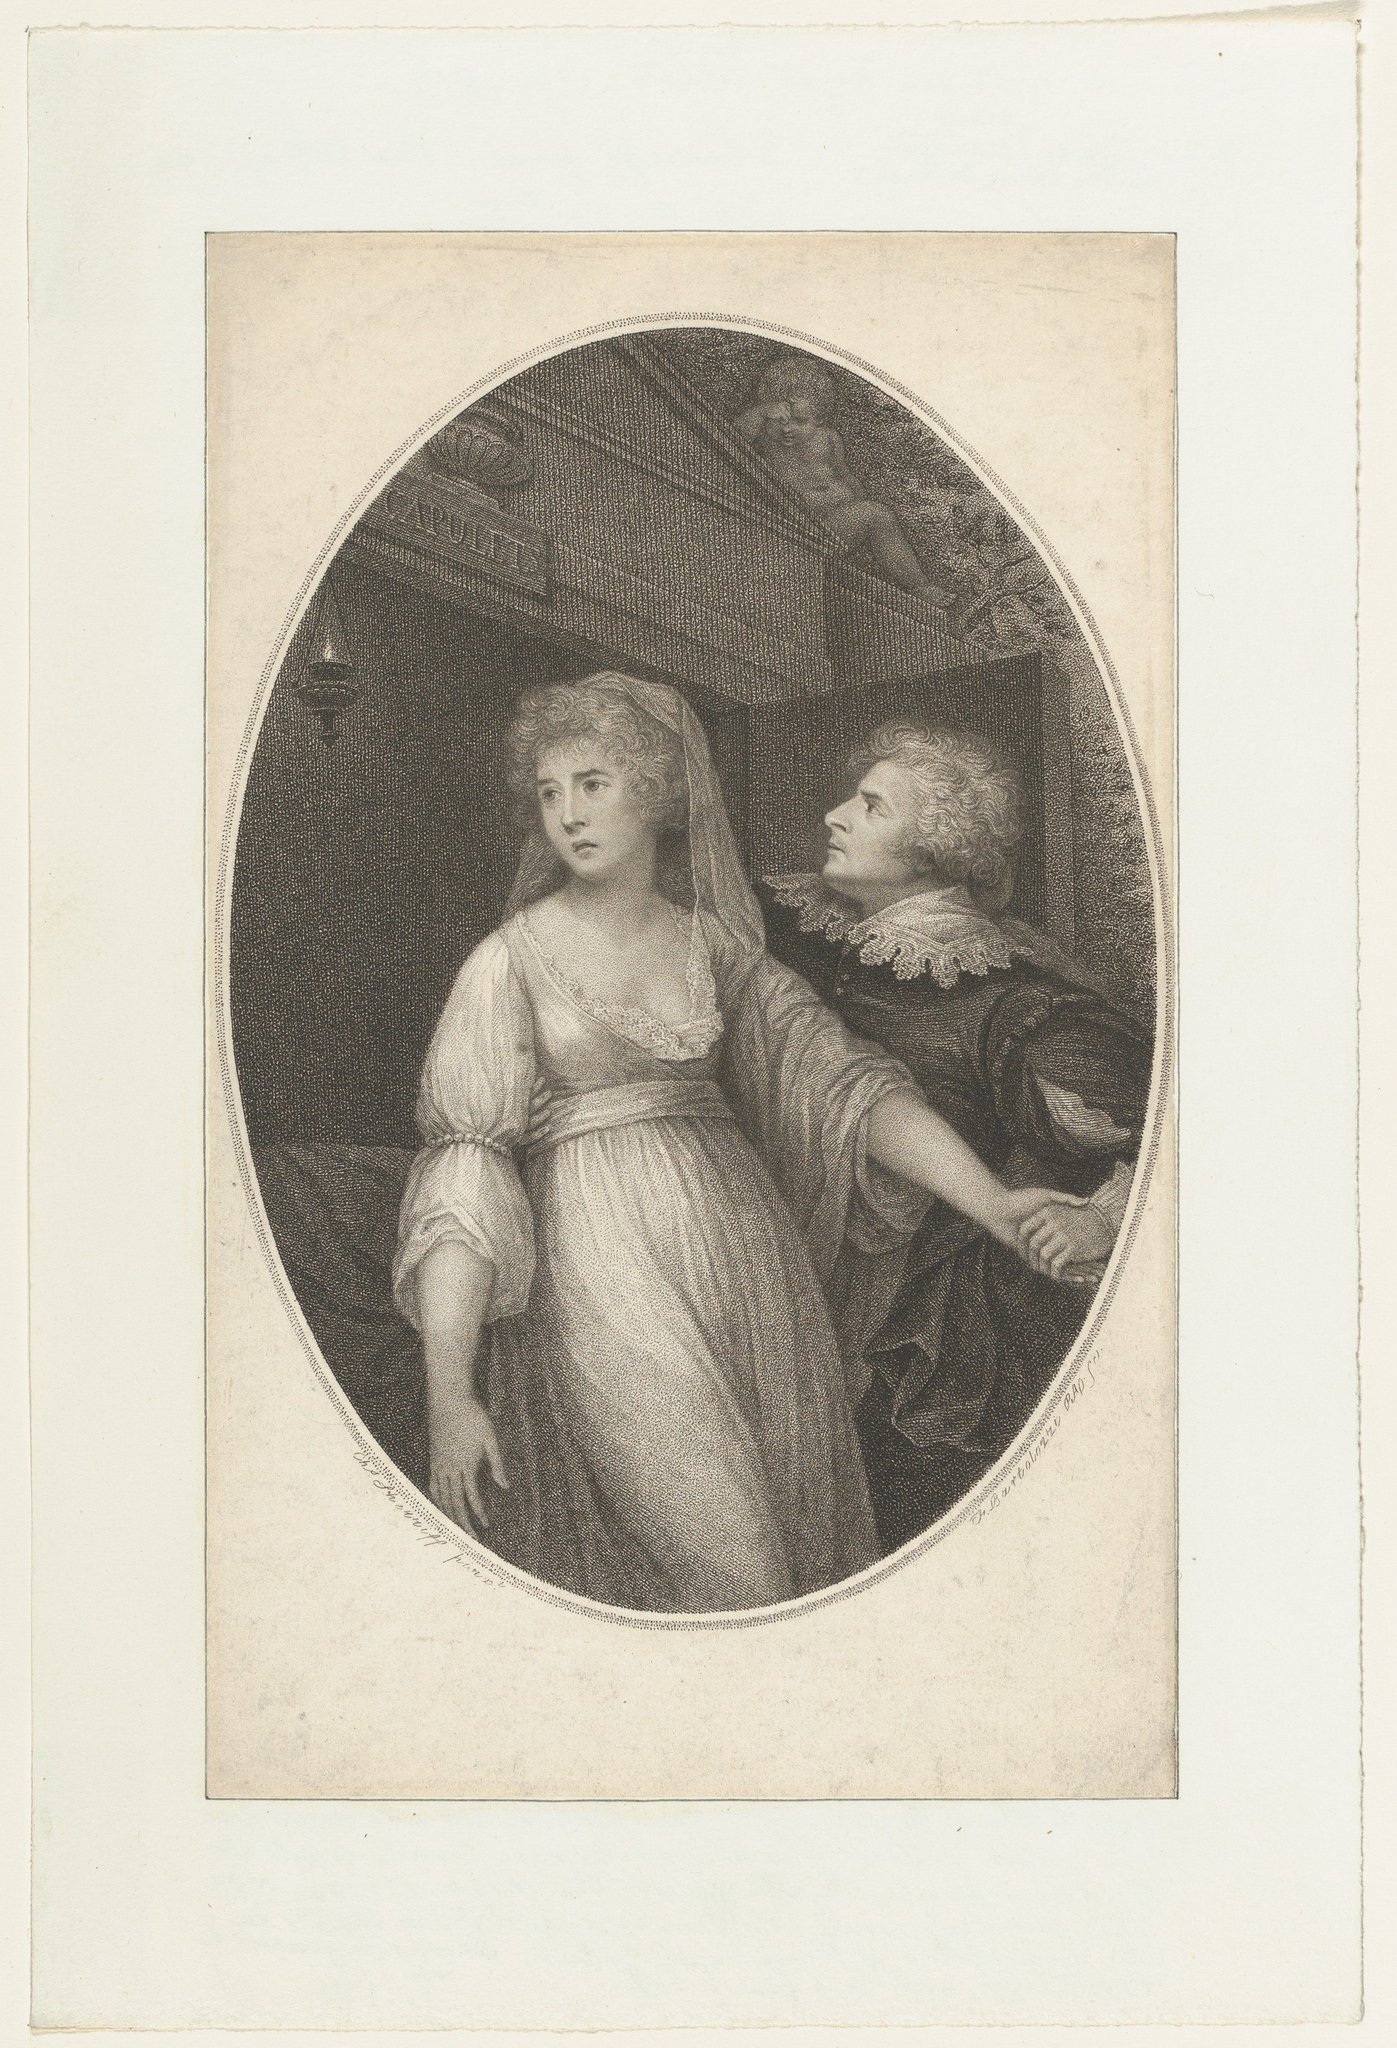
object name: print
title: Mr. Dimond and Miss Wallis in the Characters of Romeo and Juliet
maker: francesco bartolozzi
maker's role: artist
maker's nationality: italian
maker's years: 1728-1815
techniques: etching, engraving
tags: shakespeare,men,women,actors